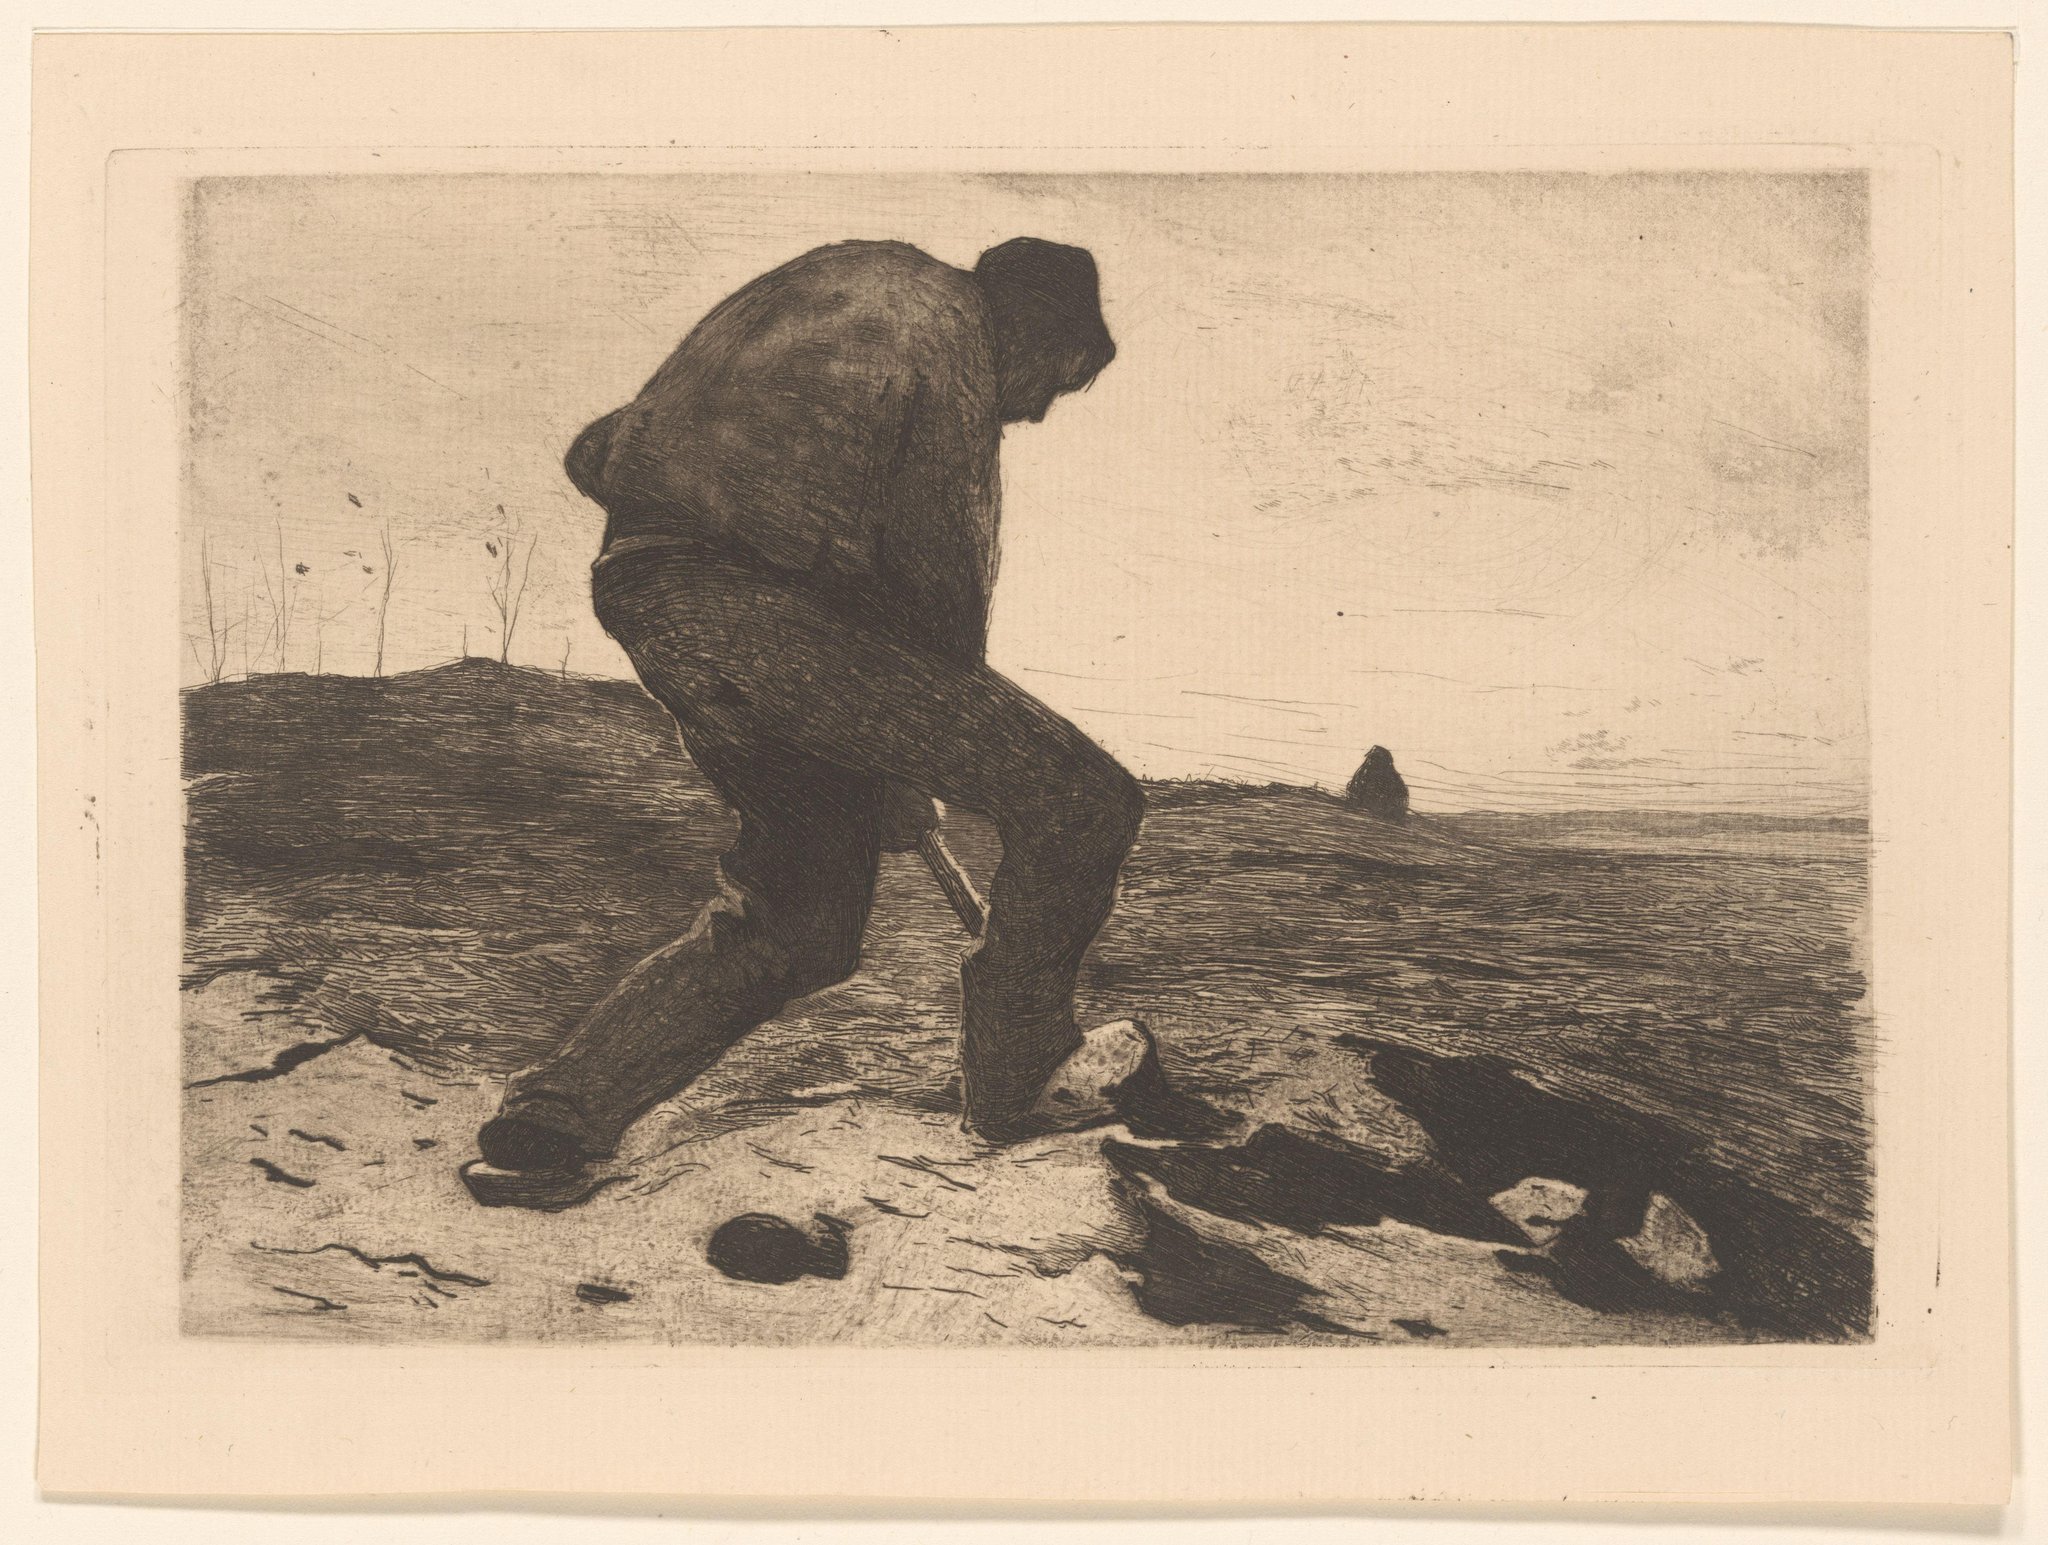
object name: print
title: Heiwerker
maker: willem witsen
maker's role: draughtsman, painter, print maker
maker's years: 1860-1923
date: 1888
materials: paper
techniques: etching, intaglio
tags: adult man, pushing something